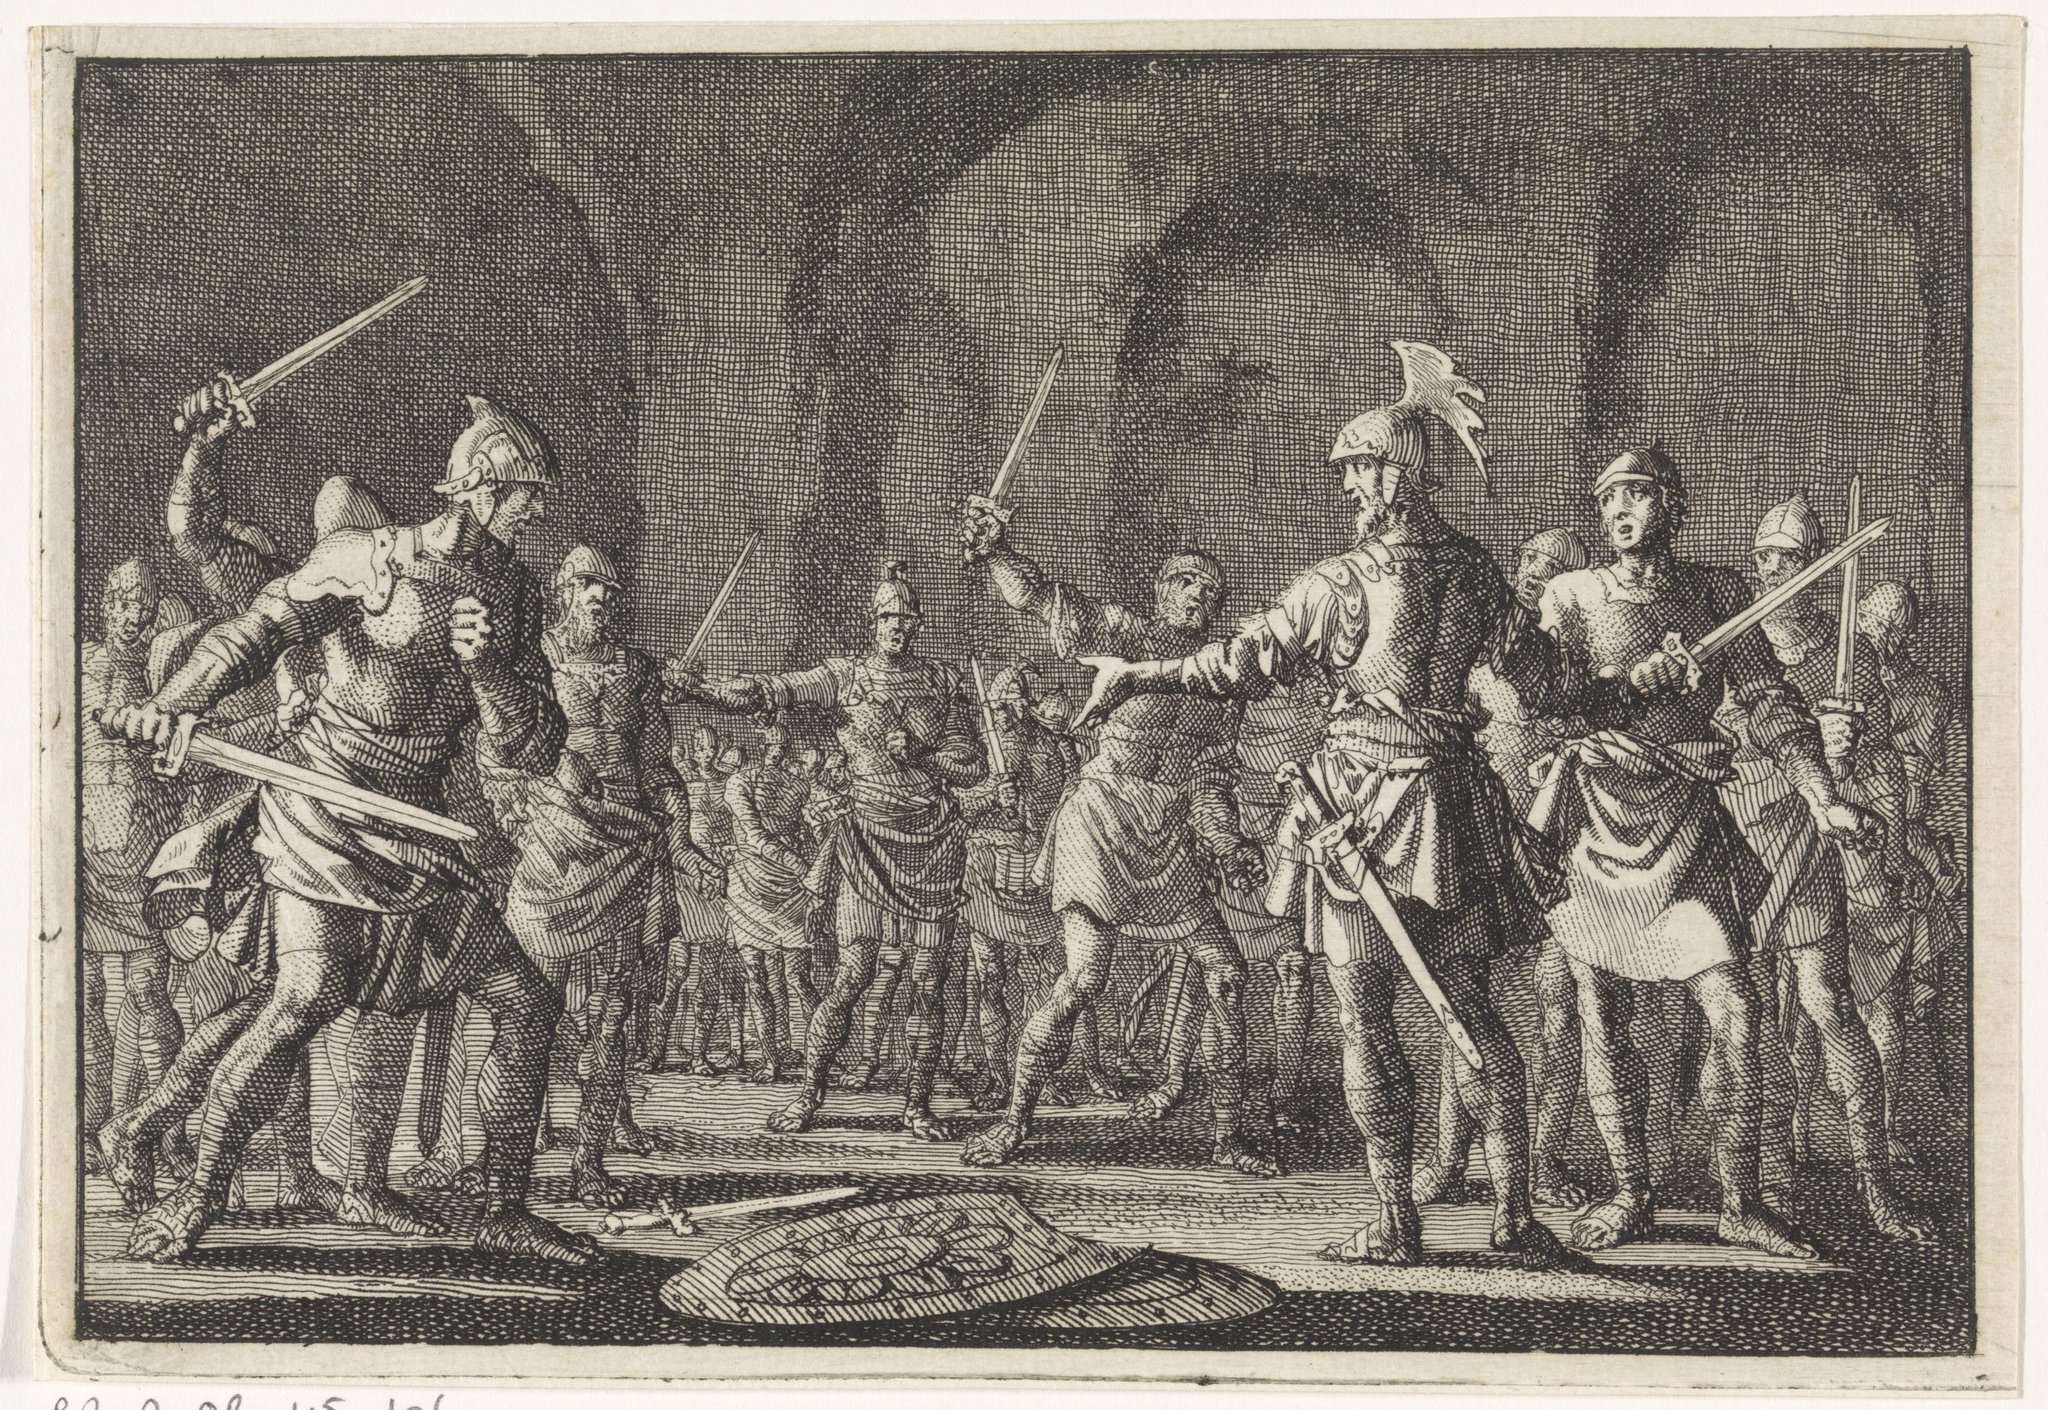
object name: print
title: Josephus na de verovering van Jotapata met 40 metgezellen in een grot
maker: jan luyken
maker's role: draughtsman, print maker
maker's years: 1649-1712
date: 1704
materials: paper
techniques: etching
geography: amsterdam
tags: cave, grotto, meeting of soldiers and/or officers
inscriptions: collector's mark: Lugt 2228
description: Prent ook gebruikt als boekillustratie in: Josephus, Flavius. Alle de Werken, 2 delen. Amsterdam: Pieter Mortier, 1704, dl. 2, p. 613.